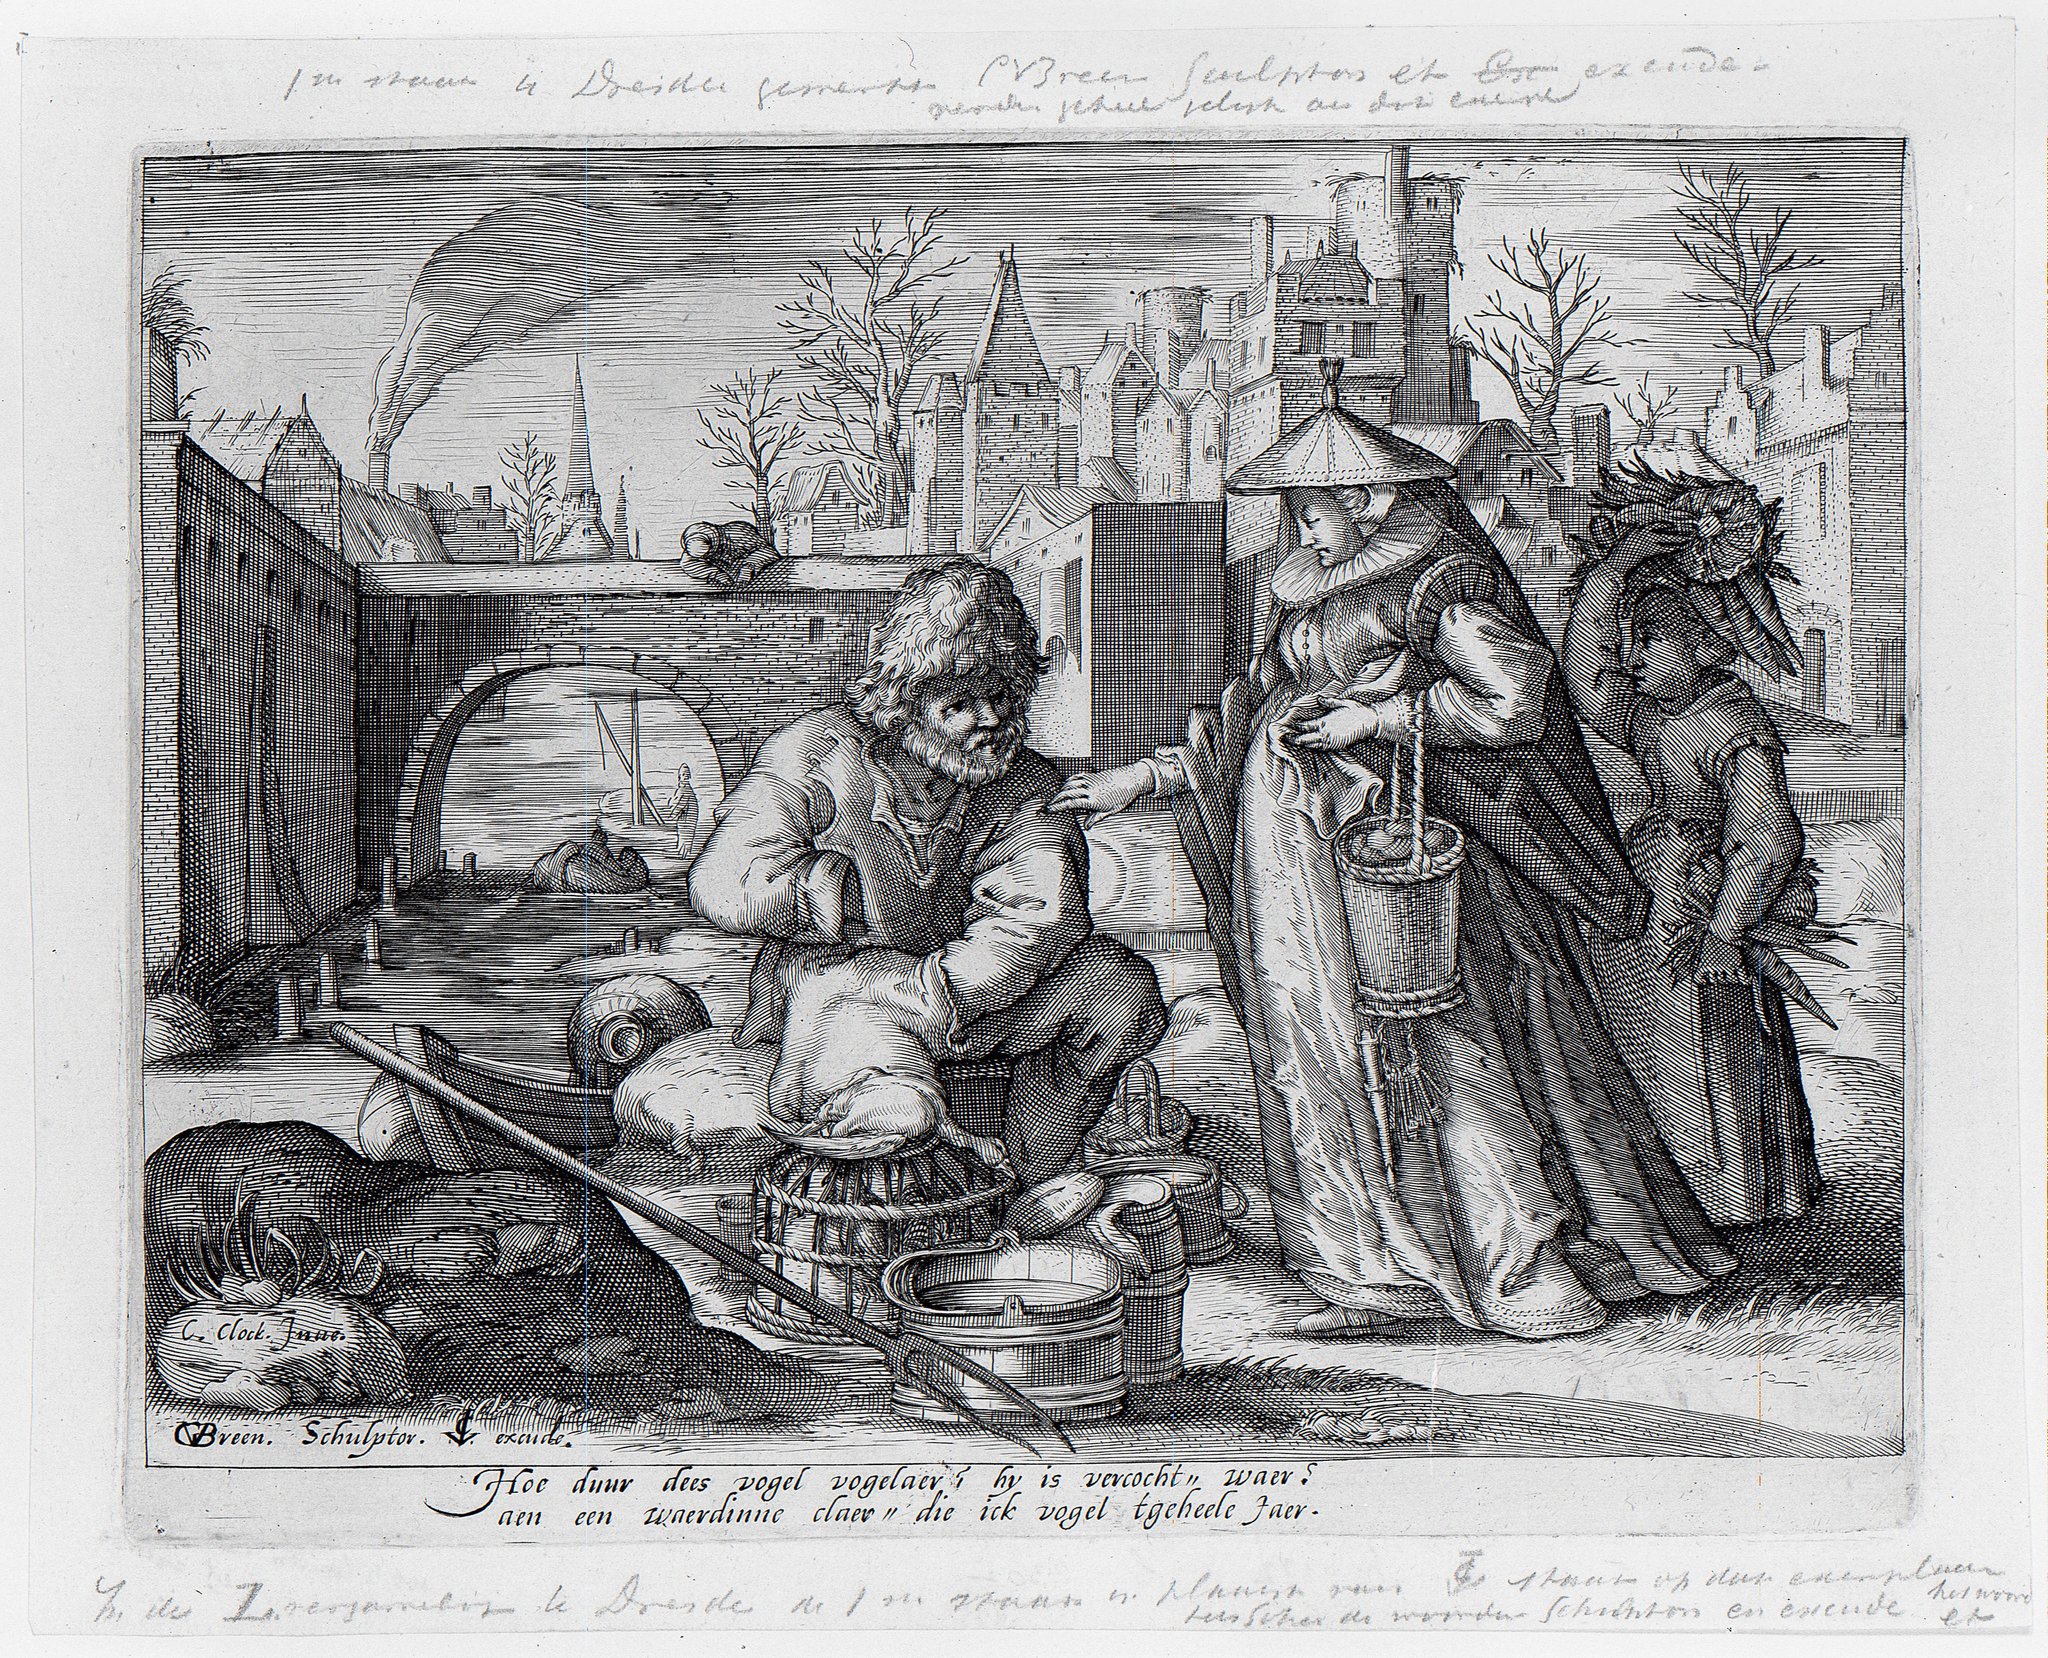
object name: print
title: Vogelkoper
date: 1595-1610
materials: paper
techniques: engraving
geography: amsterdam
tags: birds, coat (+ men's clothes), cape (huik) (+ women's clothes), head-gear: cap (+ men's clothes), street-trader, coitus, cohabiting, sexual intercourse (+ variant), carrying something on the head or on the shoulders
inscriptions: collector's mark: Lugt 2228, inscription: ‘Hoe duur dees vogel vogelaer/ hy is vercocht Waer? aen een waerdinne daer/ die ick vogel tgeheele Jaer’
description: Een vrouw, met een mand eieren aan de arm, komt met haar dienstmeid bij een vogelverkoper. De dienstmeid draagt groente onder haar arm op haar hoofd. Voor de vogelverkoper staat nog één mand met een haan op de grond, erop ligt een dode eend. De vrouw wil de vogels kopen maar ze zijn al verkocht aan "een vaste klant". Dit blijkt uit het onderschrift dat een samenspraak vormt tussen dame en koopman: "Hoe duur dees vogel vogelaer? hy is vercocht" waer? aen een waerdinne clear" die ick vogel tgeheele Jaer.". De dubbelzinnigheid ligt in de werkwoordsvorm ‘vogel’: ‘die ick vogel tgeheele Jaer’ betekent hier waarschijnlijk letterlijk ‘wie ik gedurende het hele jaar gevogelte lever’, maar er wordt mee bedoeld ‘met wie ik gedurende het hele jaar de liefde bedrijf’.